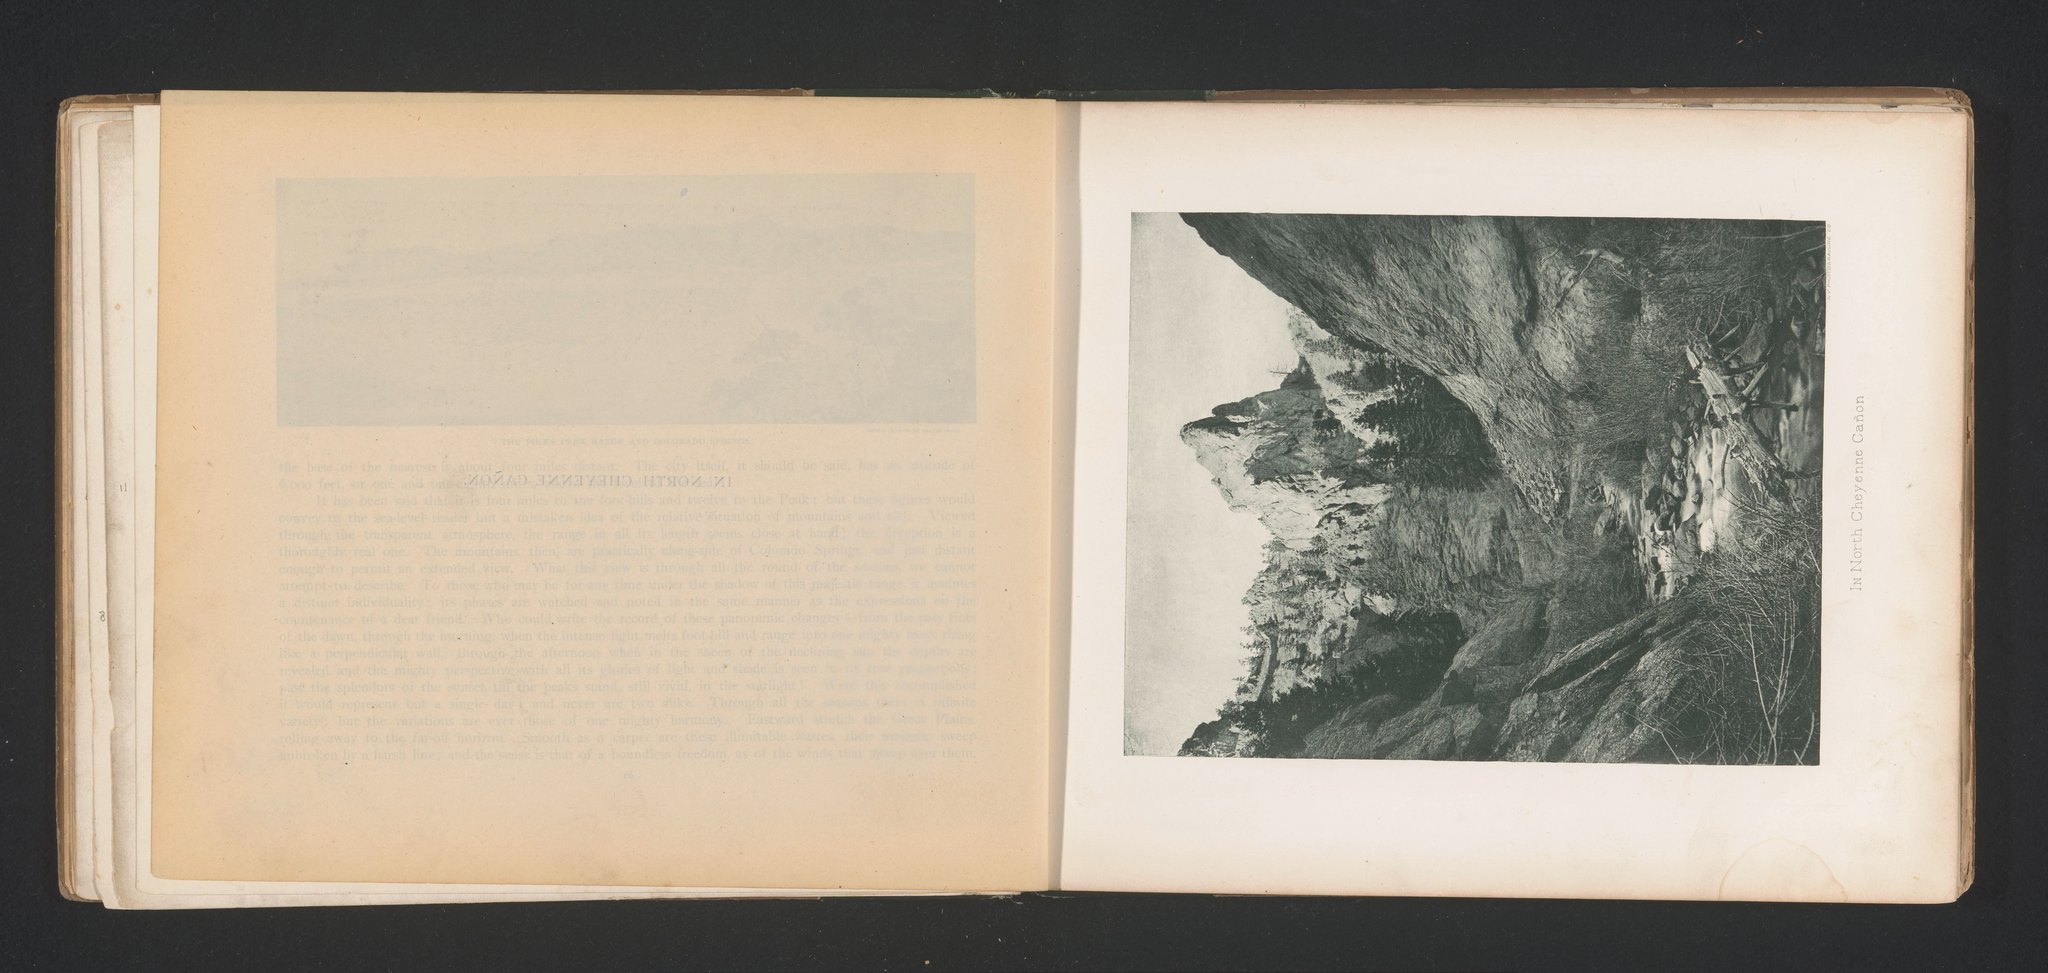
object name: page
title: Berglandschap in North Cheyenne Cañon Park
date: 1888-1893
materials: paper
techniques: photoaquatint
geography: new york city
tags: landscapes, mountains